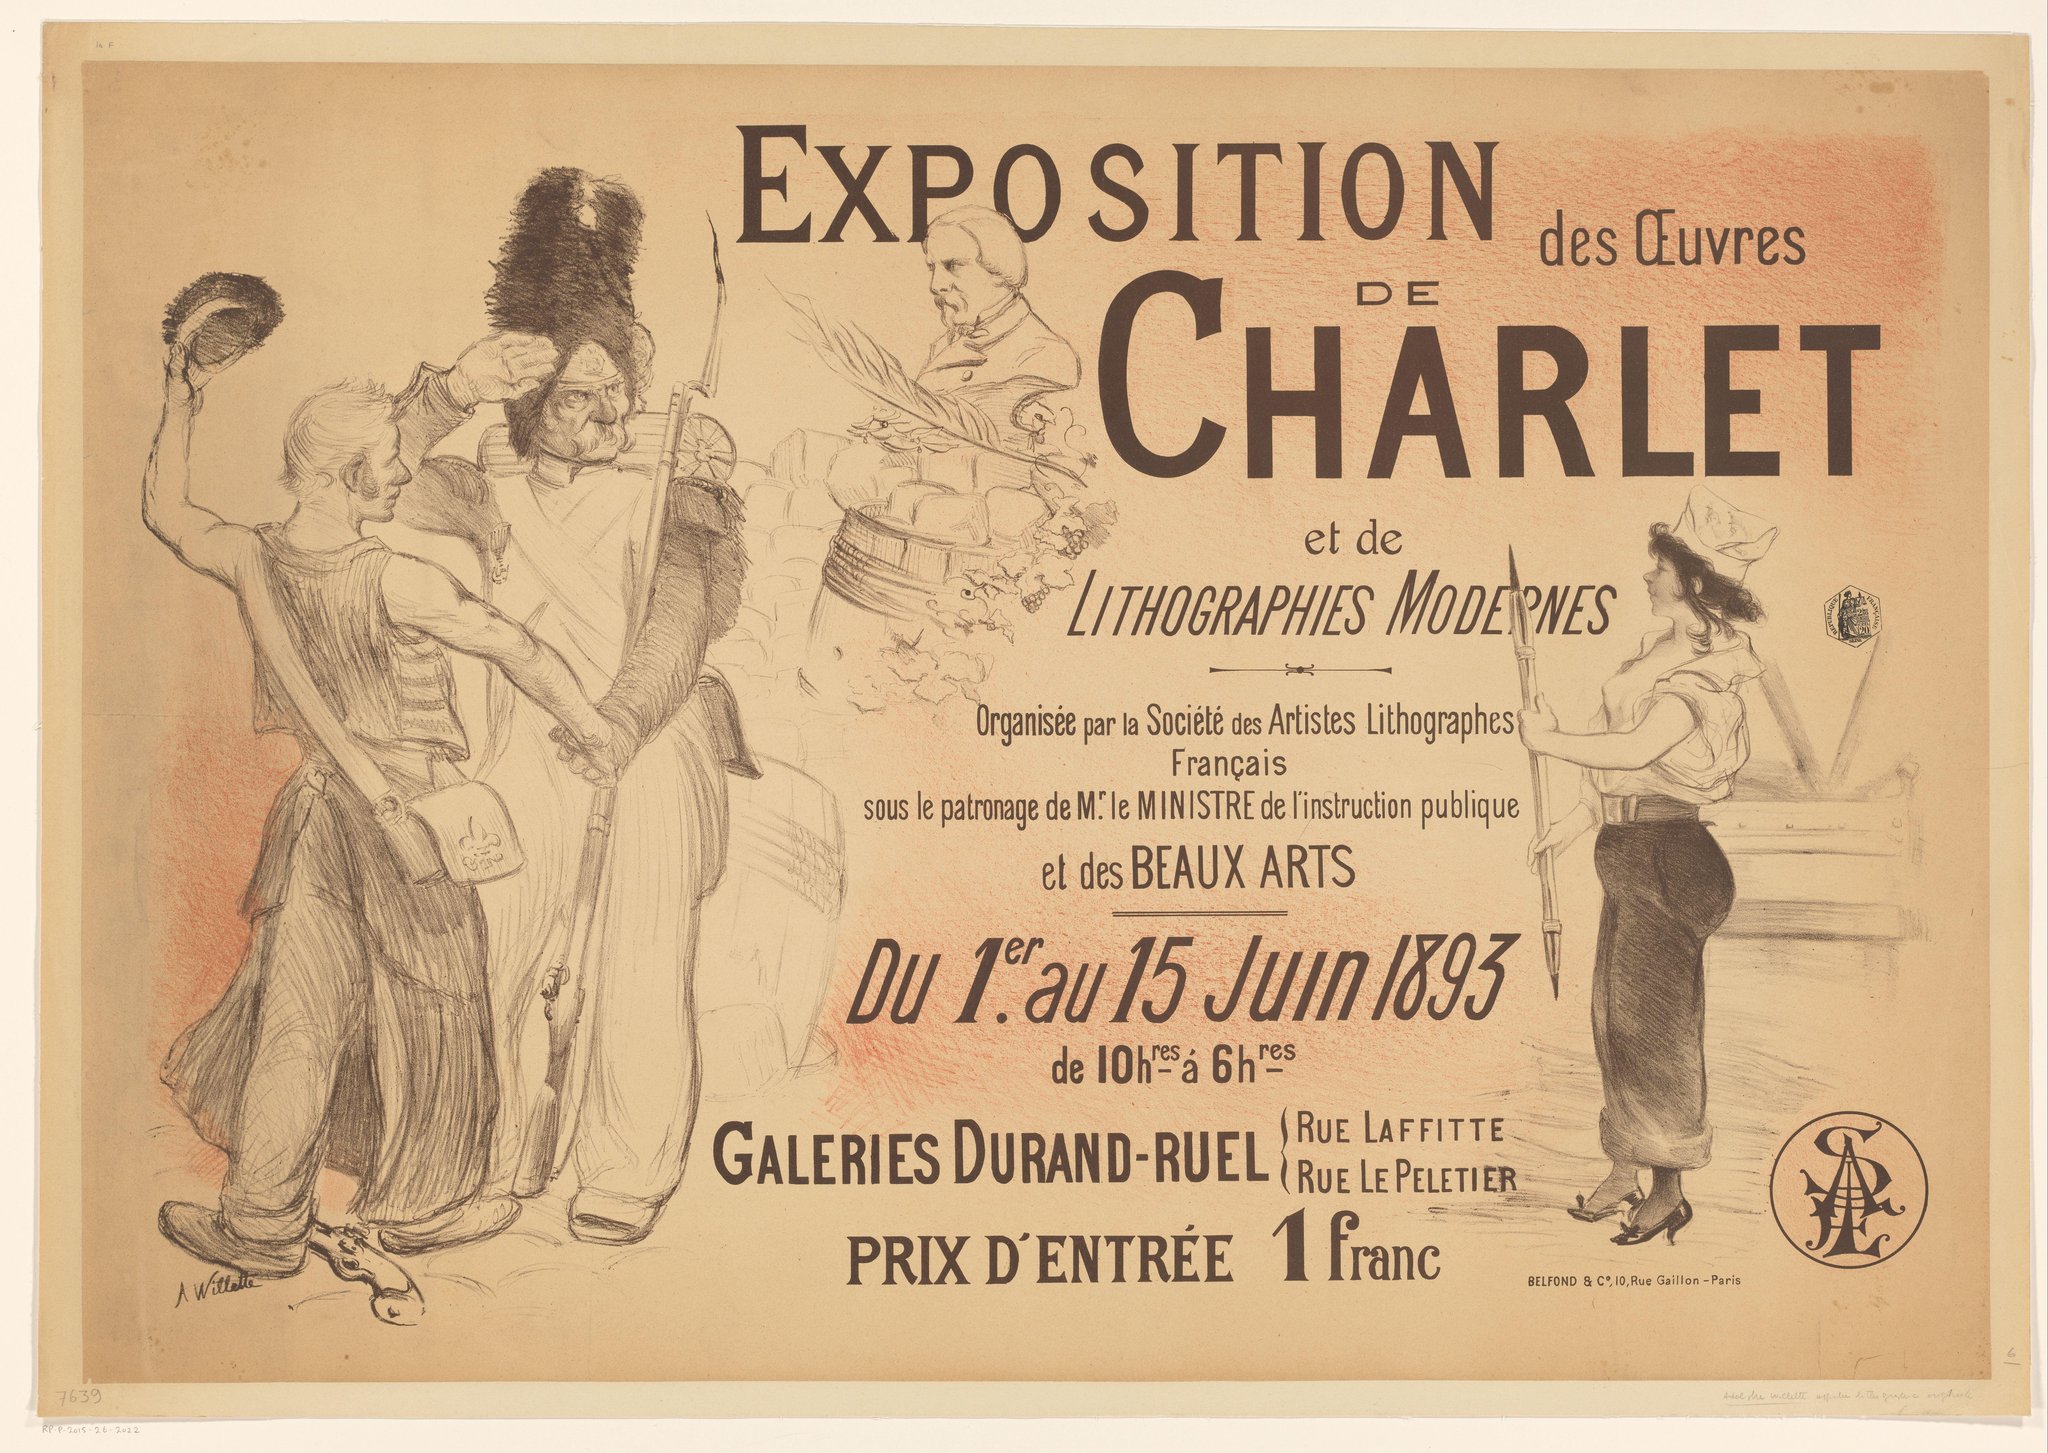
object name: print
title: Affiche voor een expositie met werk van Nicholas Toussaint Charlet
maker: adolphe léon willette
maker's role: print maker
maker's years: 1857-1926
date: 1893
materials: paper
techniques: lithograph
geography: paris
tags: paris, painter, print maker, draughtsman, printer, nicolas toussaint charlet, private soldier, tools, implements of graphic artist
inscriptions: collector's mark: Lugt 4779, stamp: ‘Republique Française Seine / 2 mes 20 ensus / cen. 20’, collector's mark: Lugt 2228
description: Affiche voor een expositie met werk van Nicholas Toussaint Charlet en andere prentmakers, georganiseerd door de Société des Artistes Lithographes Français in de Galeries Durand-Ruel van 1 tot 15 juni 1893. Links een saluerende militair uit het Republikeinse leger, hand in hand met een Franse vrijheidsstrijder die zijn pet omhoog houdt; een pistool naast zijn voeten. Rechts een vrouw met ontbloot bovenlijst voor een lithopers met een krijthouder in haar handen. Links in de achtergrond het portret van Nicholas Toussaint Charlet.